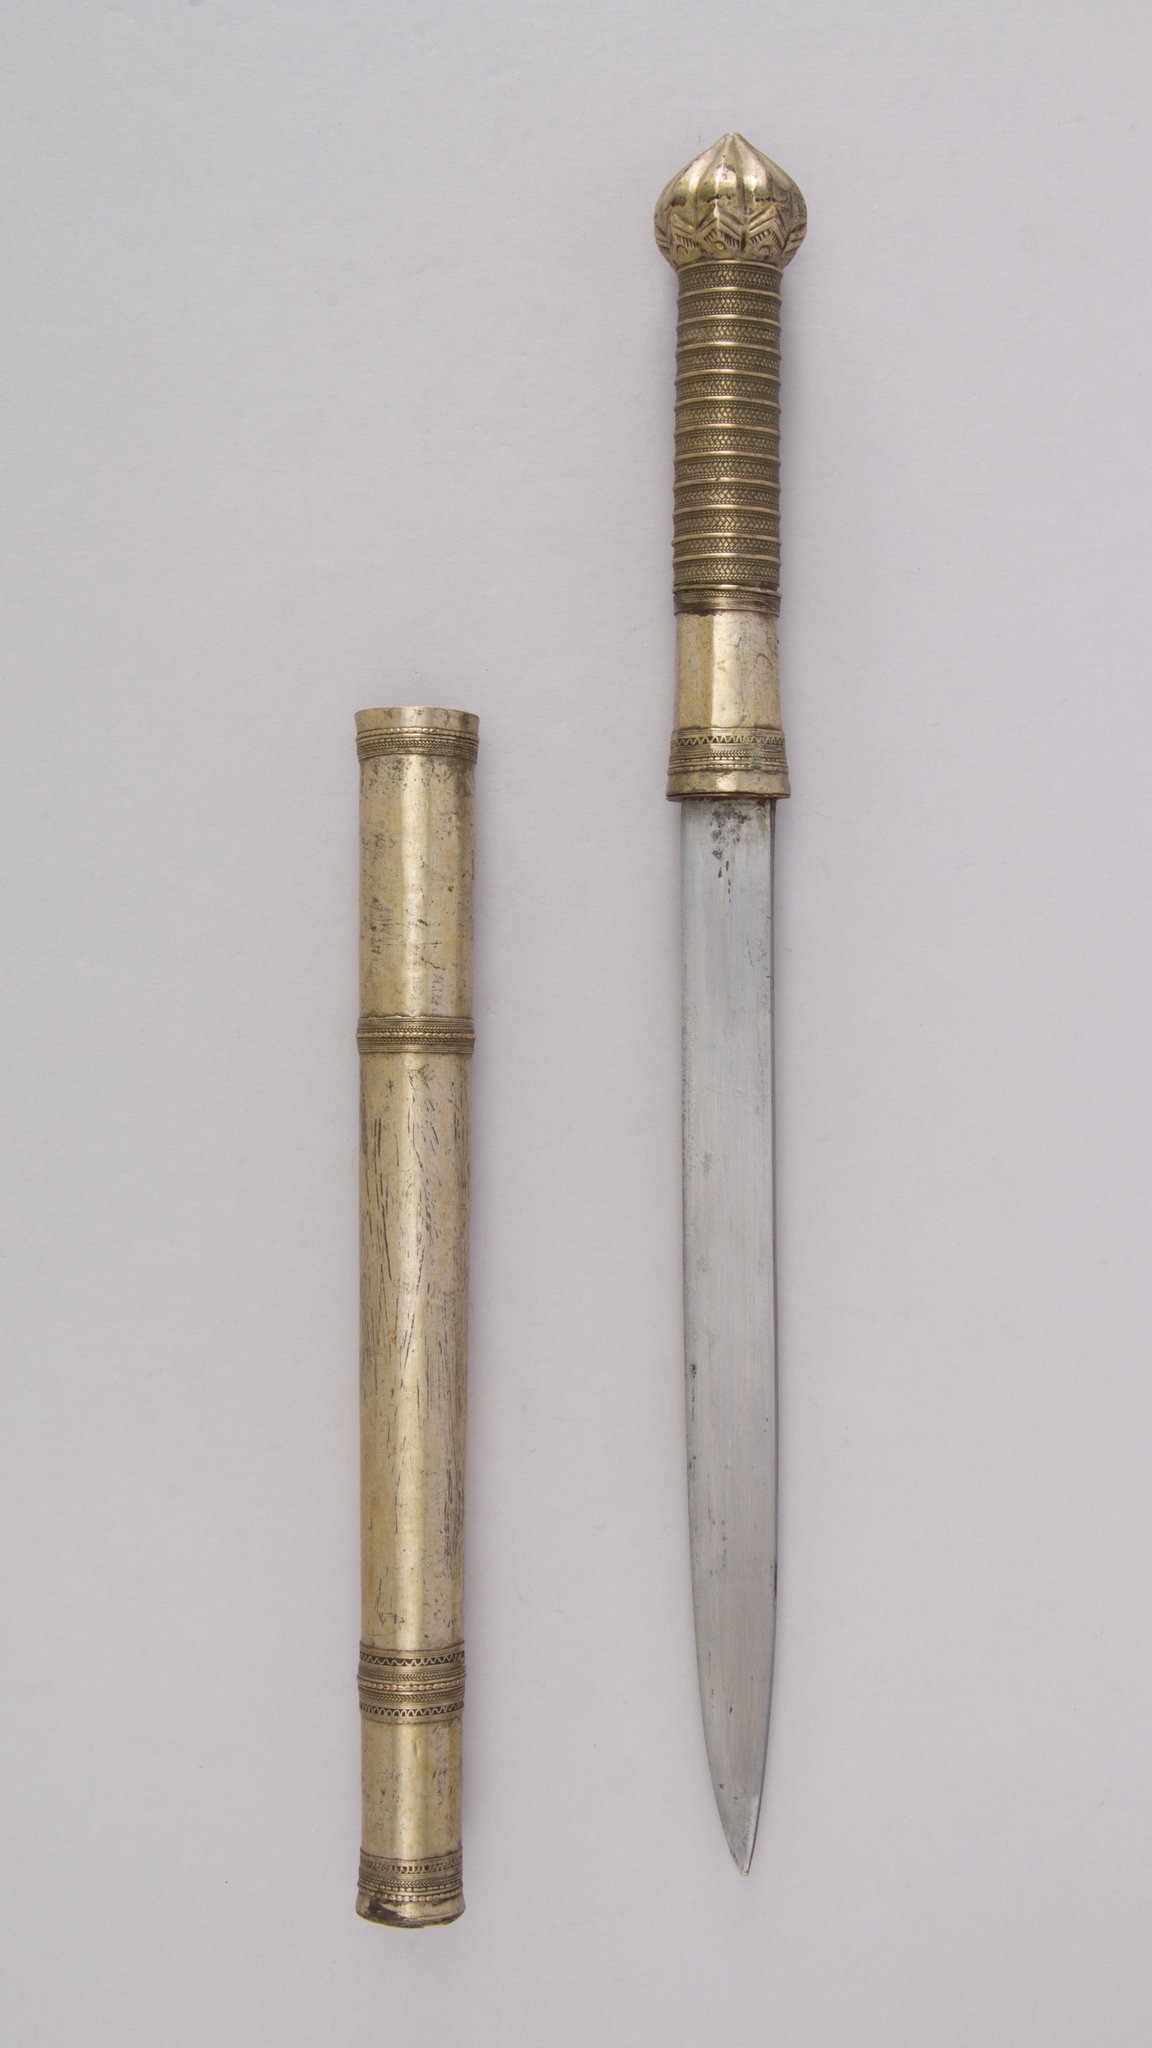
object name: knife with sheath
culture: thai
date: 1701-1900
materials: silver, steel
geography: thailand